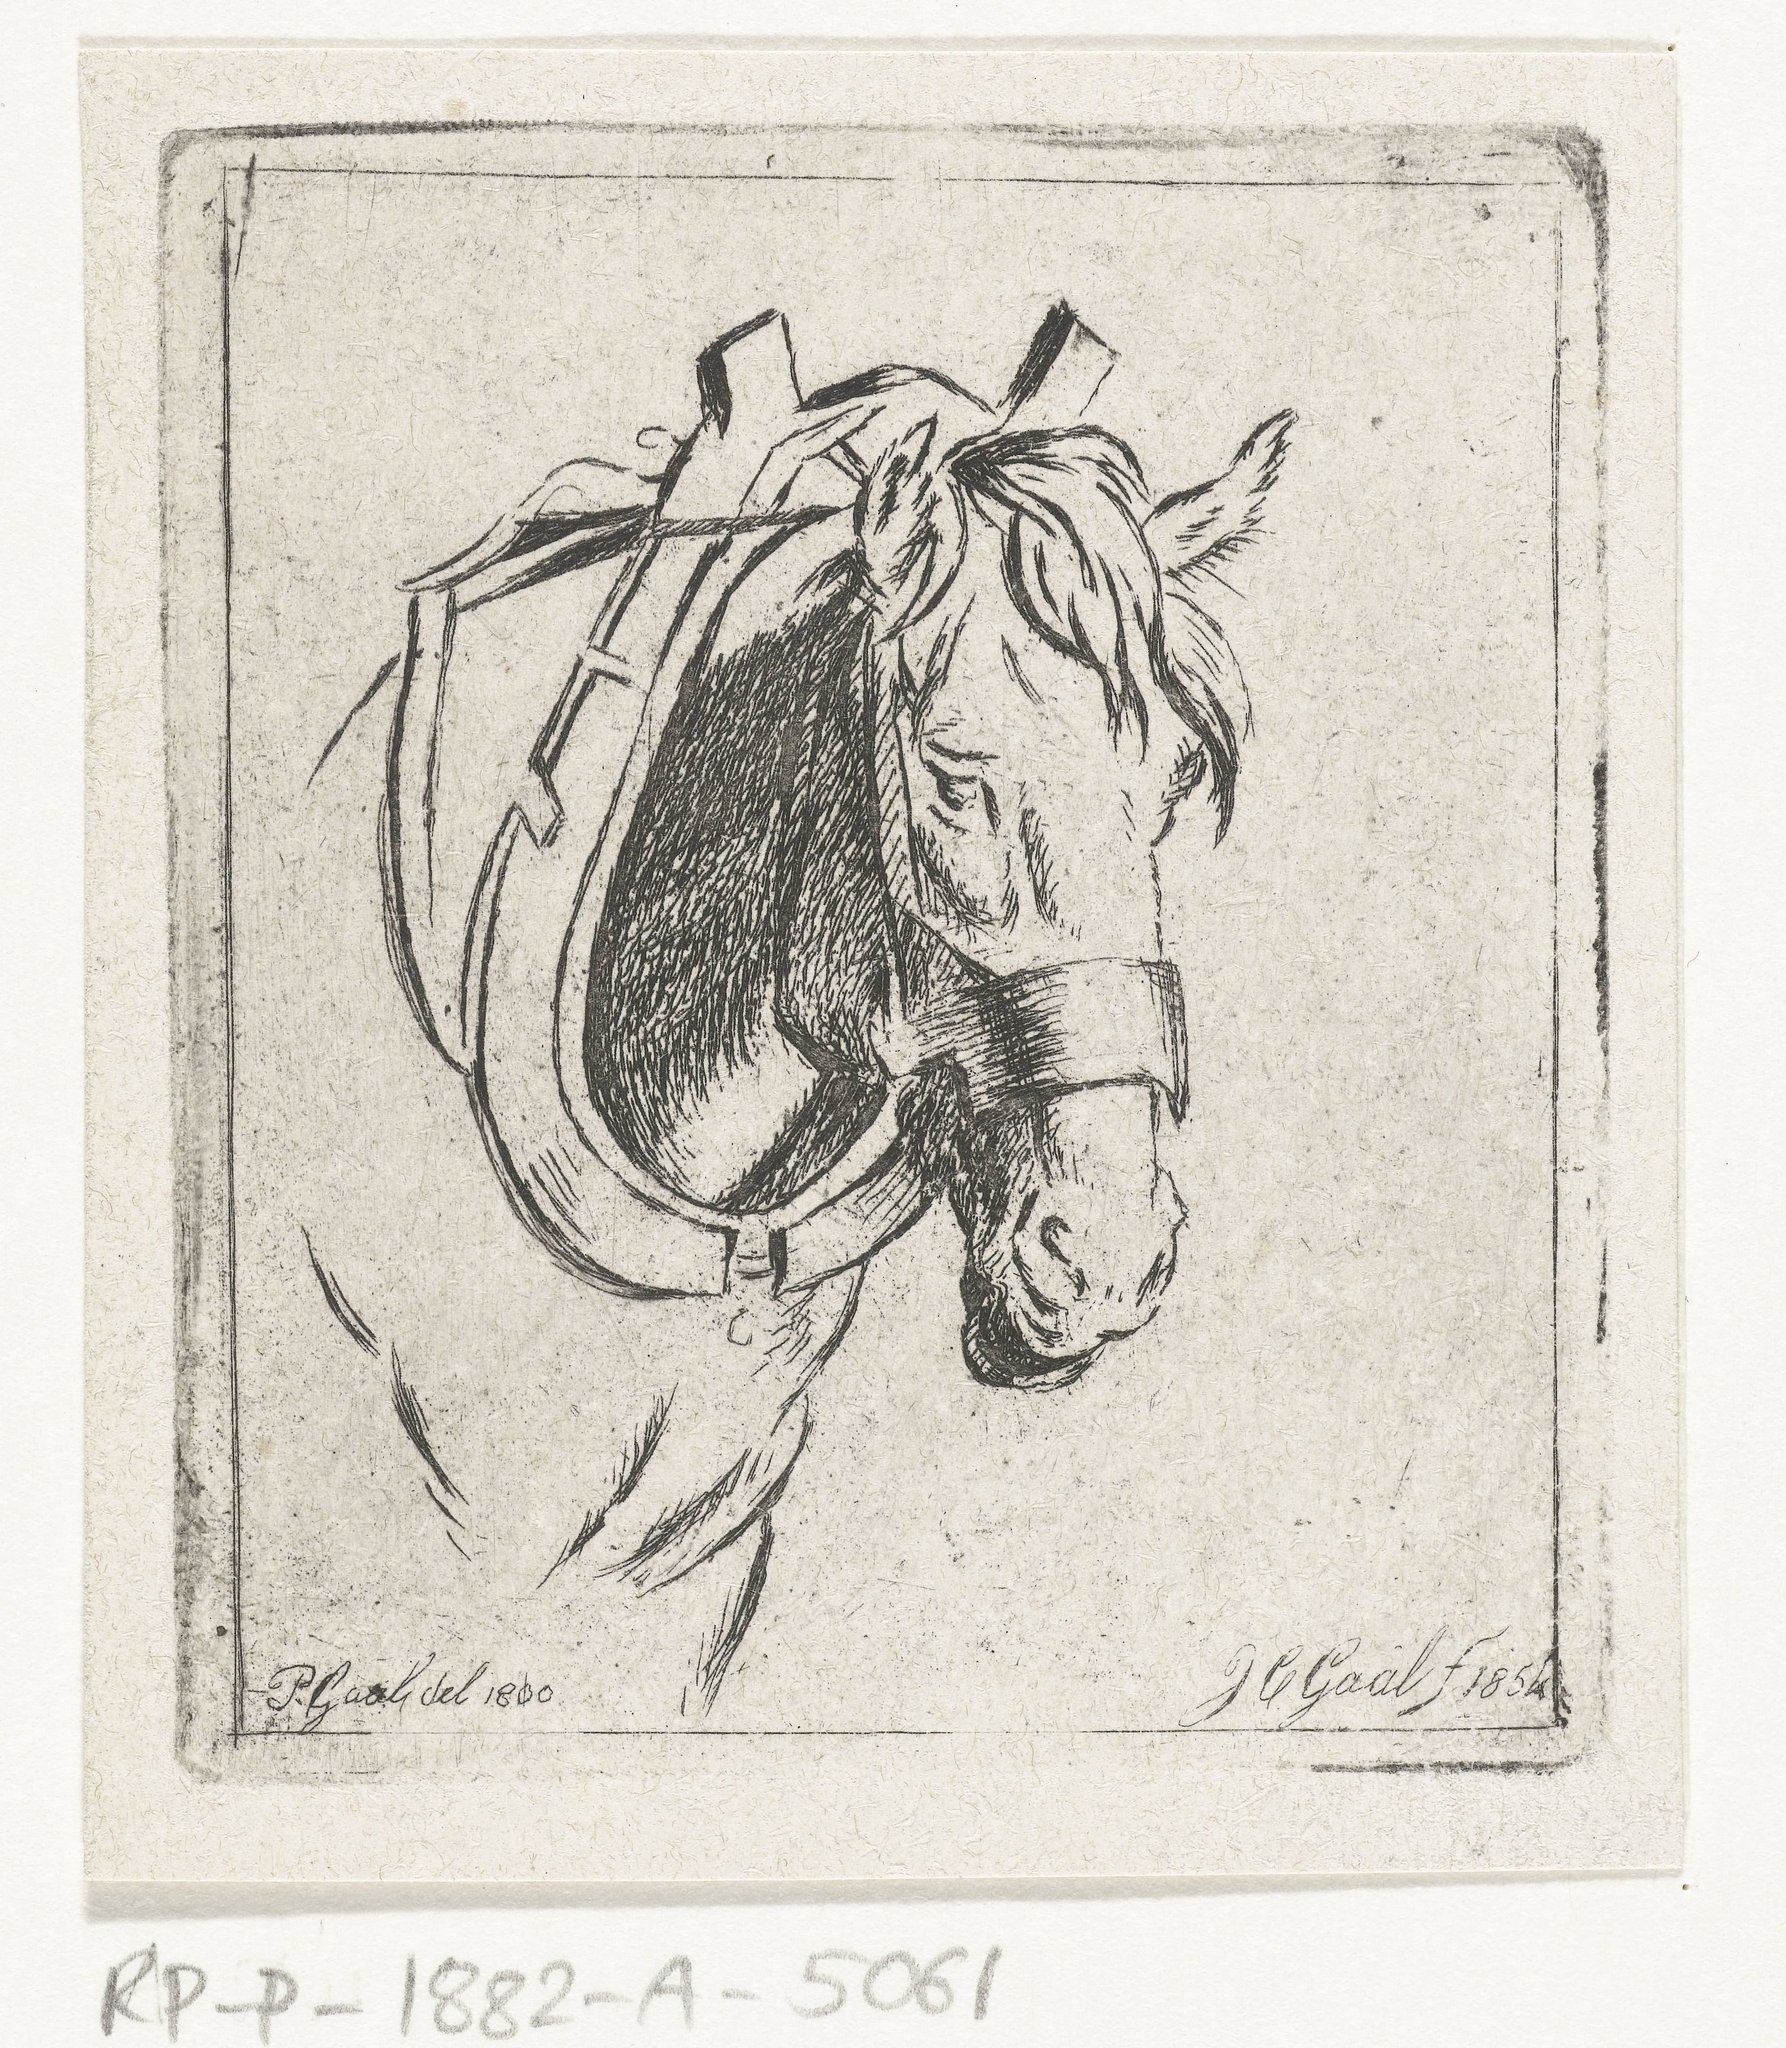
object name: print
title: Hoofd van een paard met juk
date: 1854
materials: paper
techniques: etching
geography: netherlands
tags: horse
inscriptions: collector's mark: Lugt 2228